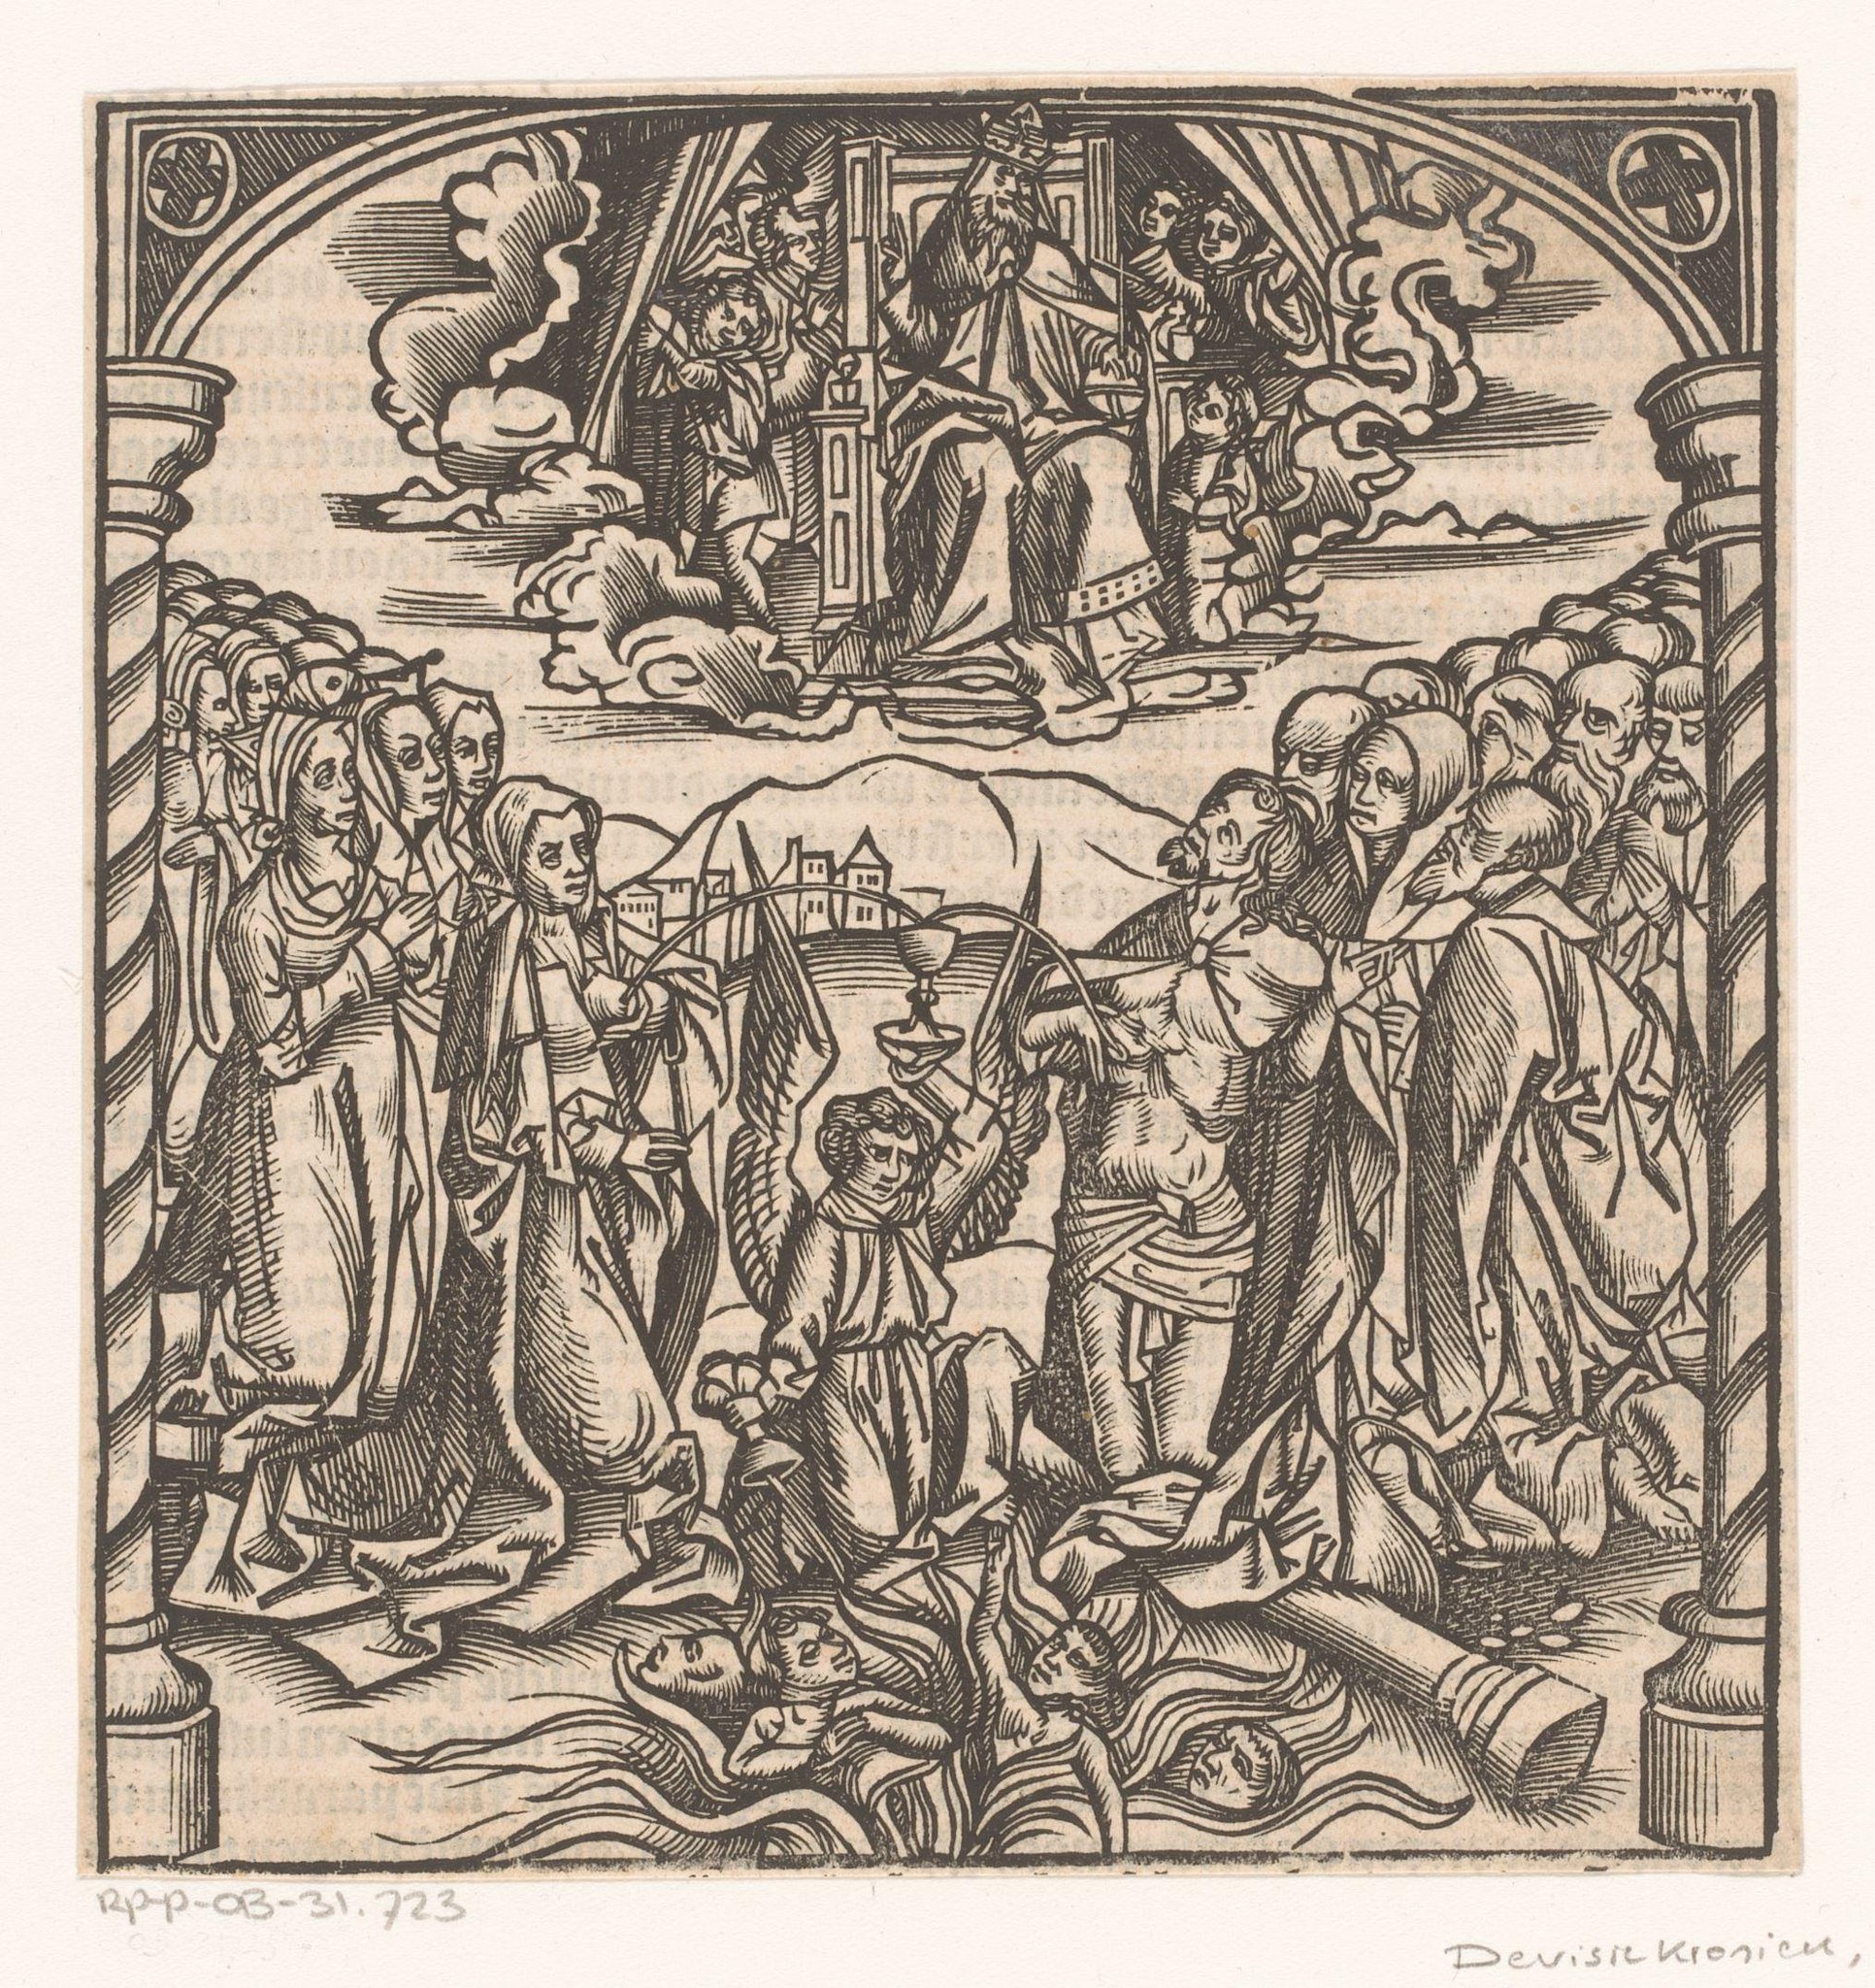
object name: book illustration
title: Knielende engel een straal bloed van Christus en een straal melk van Maria in een kelk vangend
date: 1517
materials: paper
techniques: letterpress printing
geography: netherlands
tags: the virgin mary, angel(s) catching christ's blood in cup(s), christ, mary giving milk from her breasts, 'lactatio', angels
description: Prent uit: Aurelius, Cornelius. Die cronycke van Hollandt Zeelandt en̄ Vrieslant. Leiden: Jan Seversz, 1517.